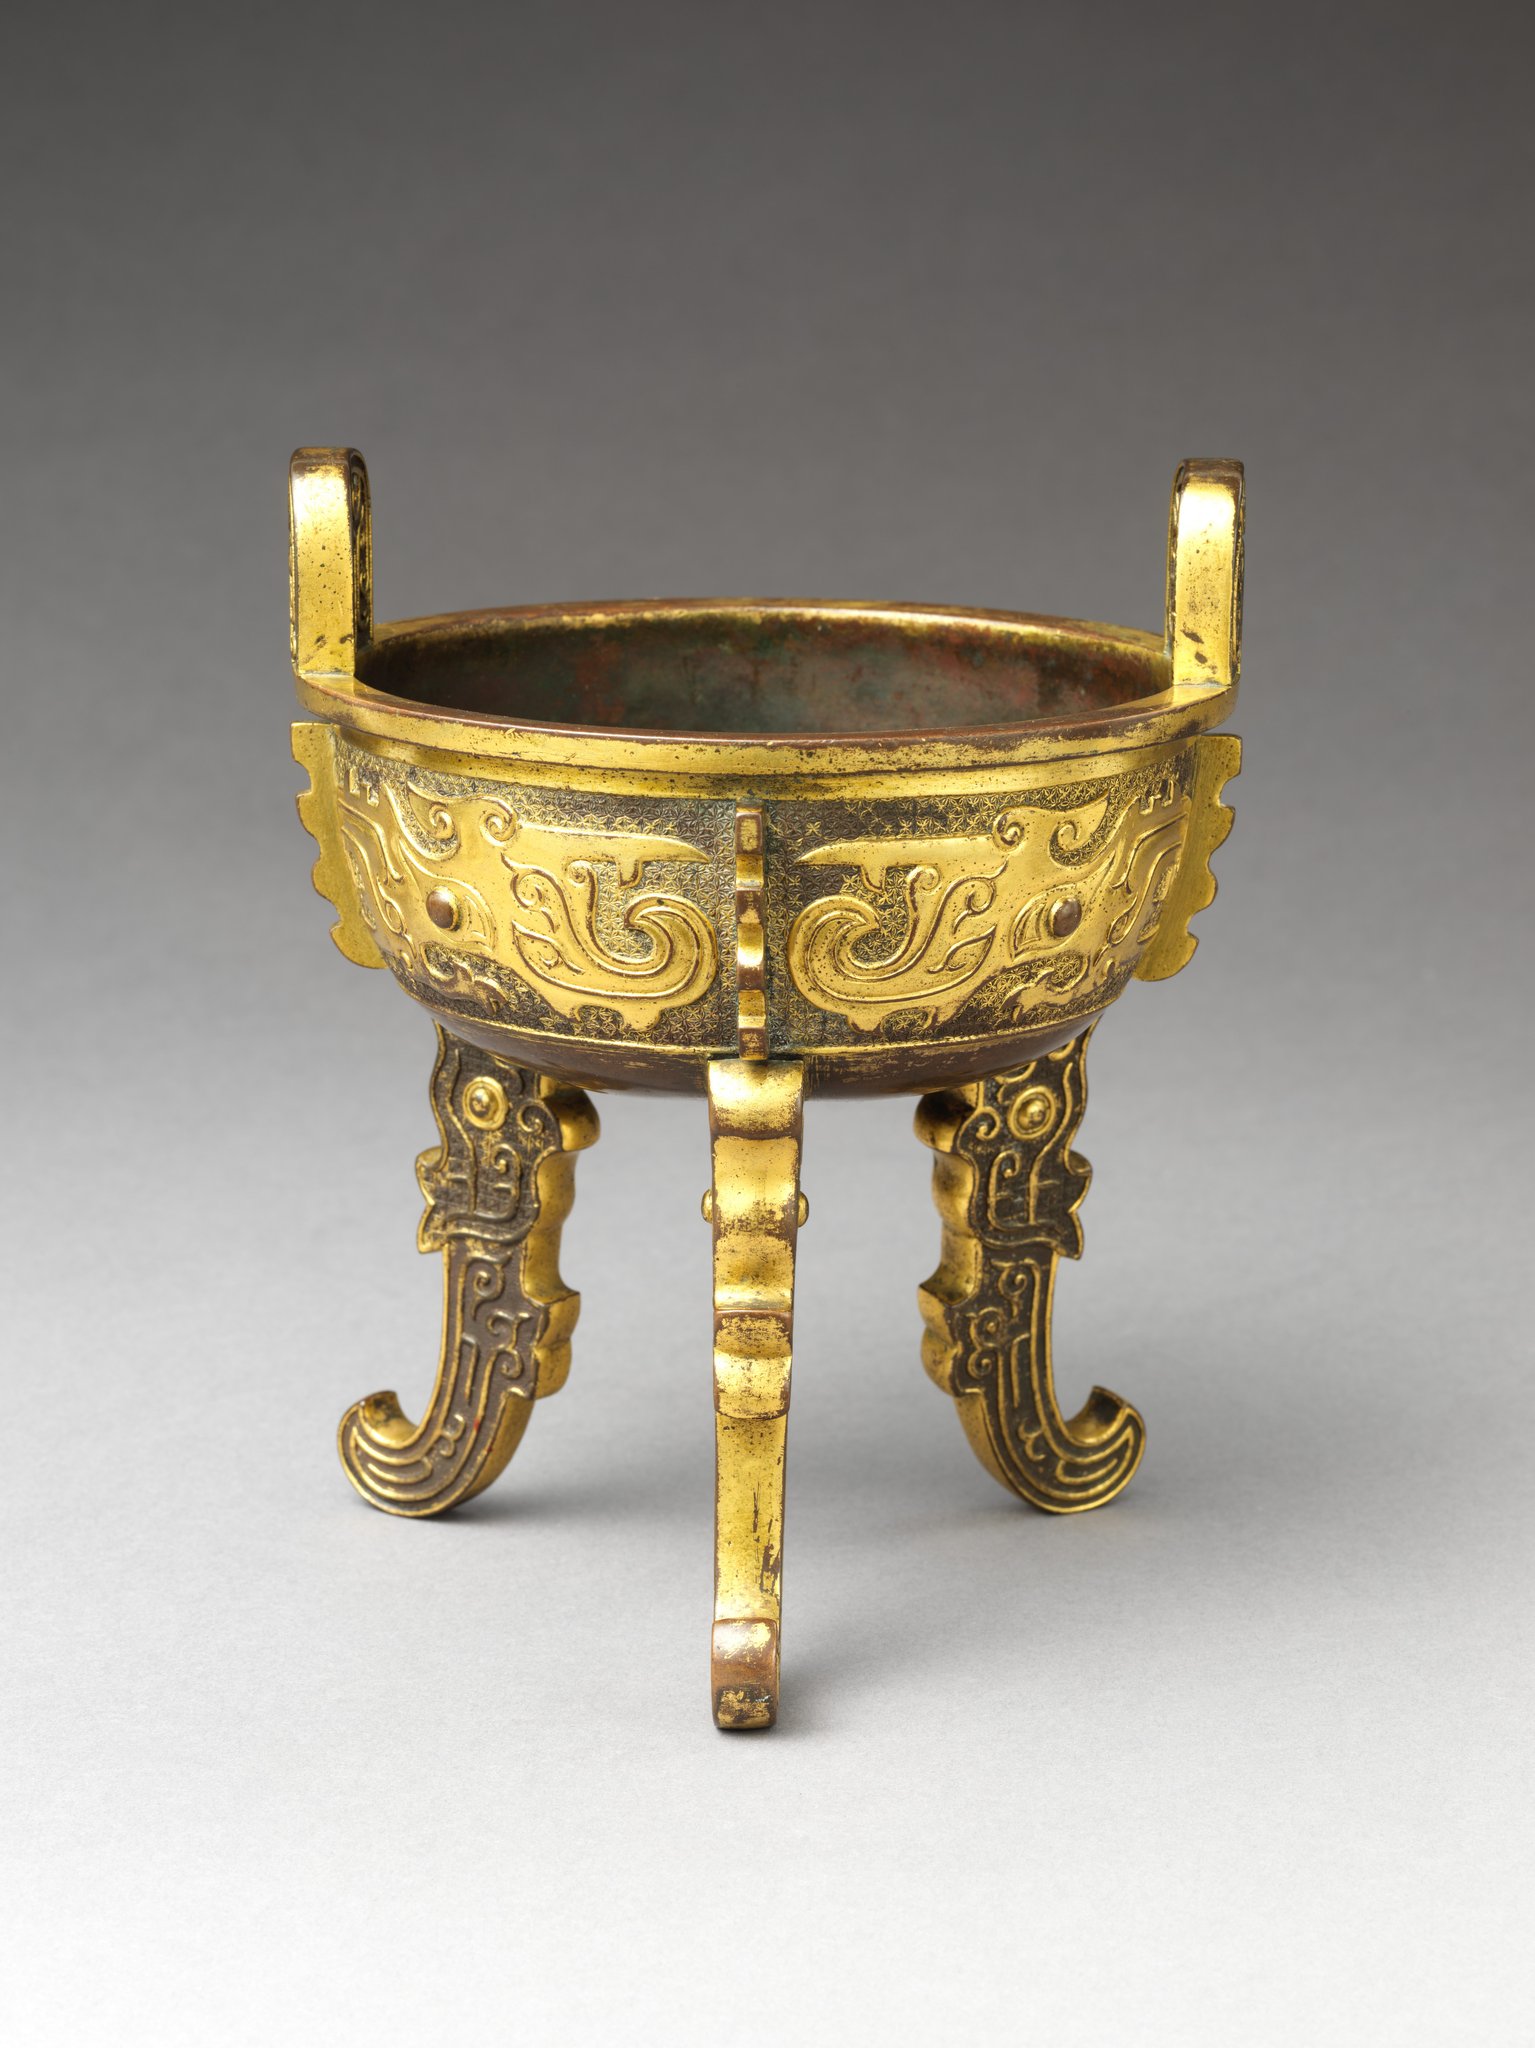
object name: censer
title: Archaistic tripod censer (ding)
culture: chinese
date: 1601-1700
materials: copper alloy, gilt